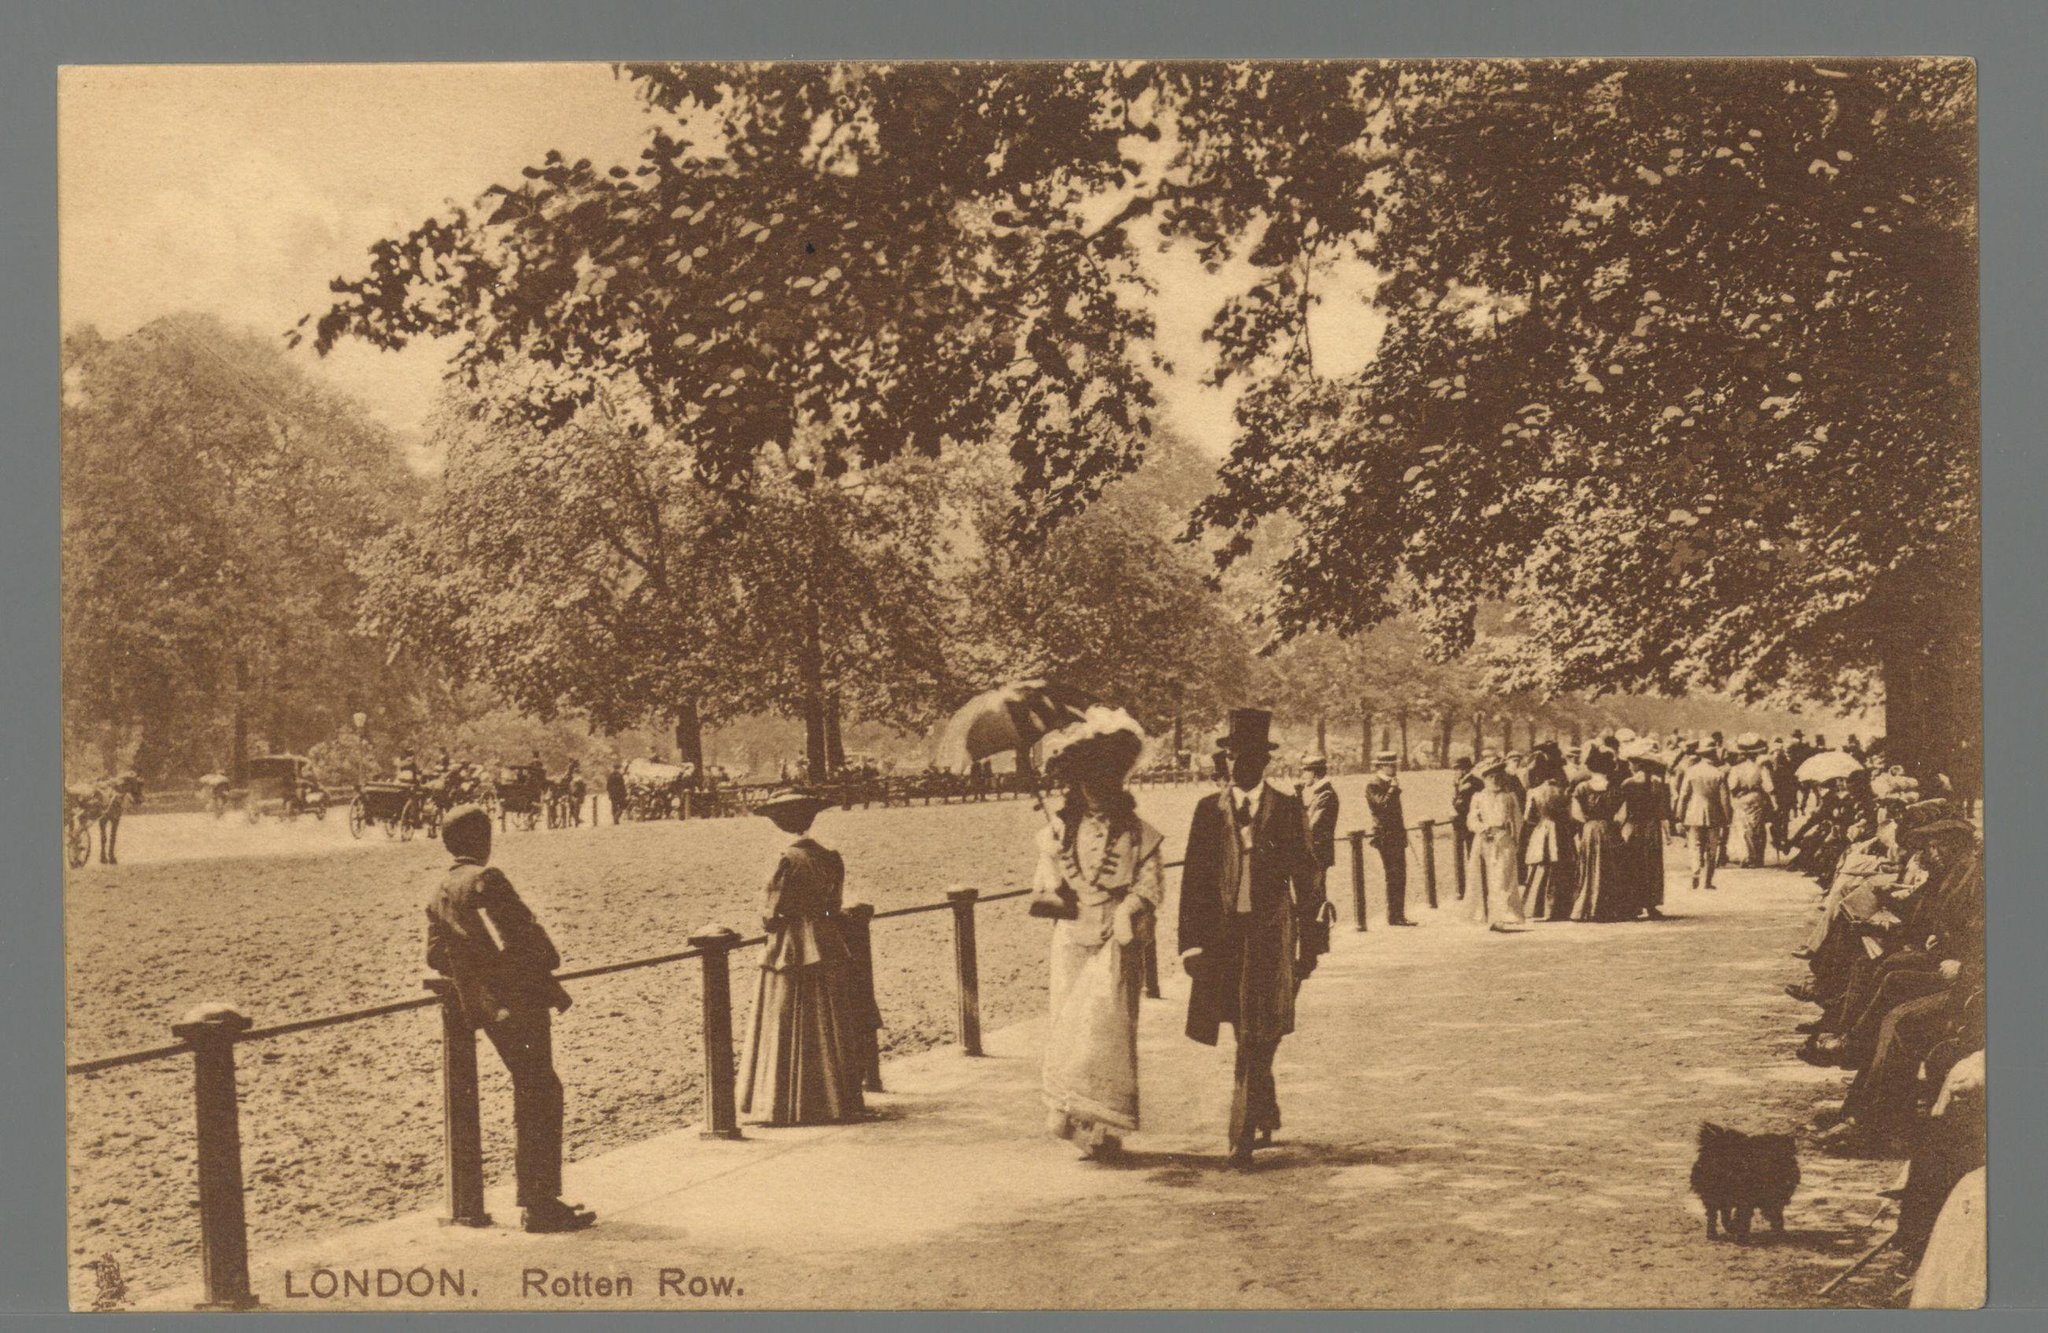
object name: ansichtkaart, prentbriefkaart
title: London. Rotten Row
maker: Anonymous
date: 1910-1912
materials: cardboard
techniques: photograph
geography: saxony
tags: park, road, path